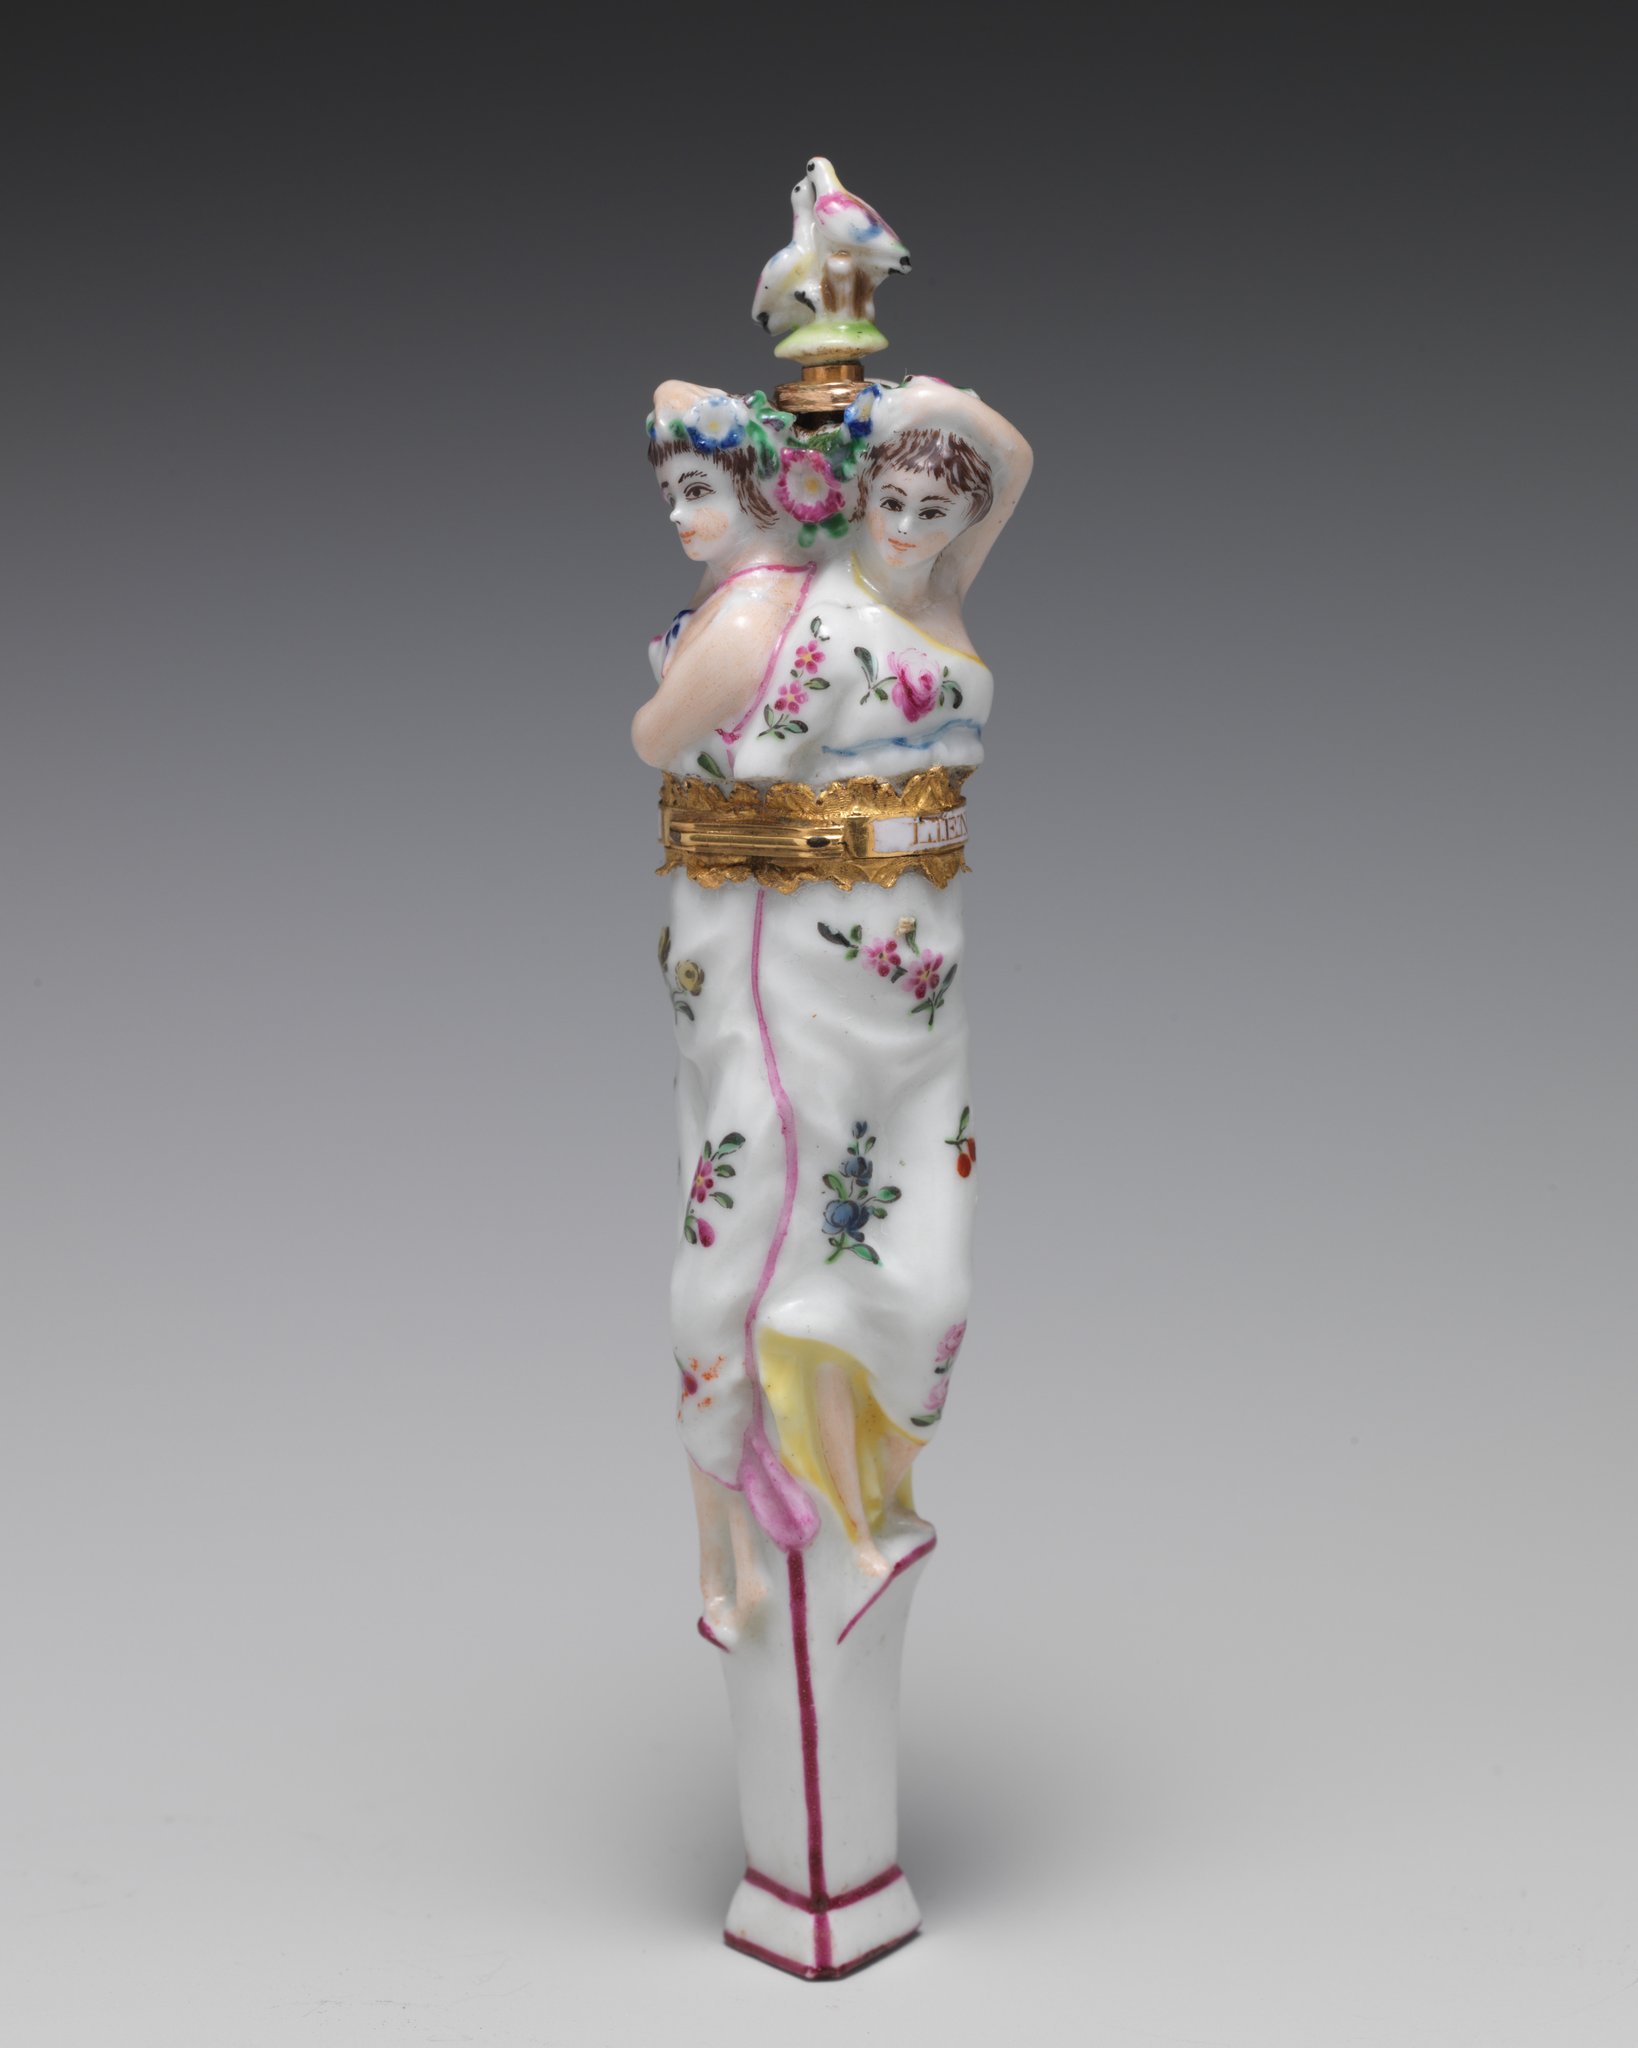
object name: toy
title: Three Graces in a group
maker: saint james's factory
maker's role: maker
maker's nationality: british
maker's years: 1749-1759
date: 1750-1755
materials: soft paste porcelain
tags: women,flowers,leaves